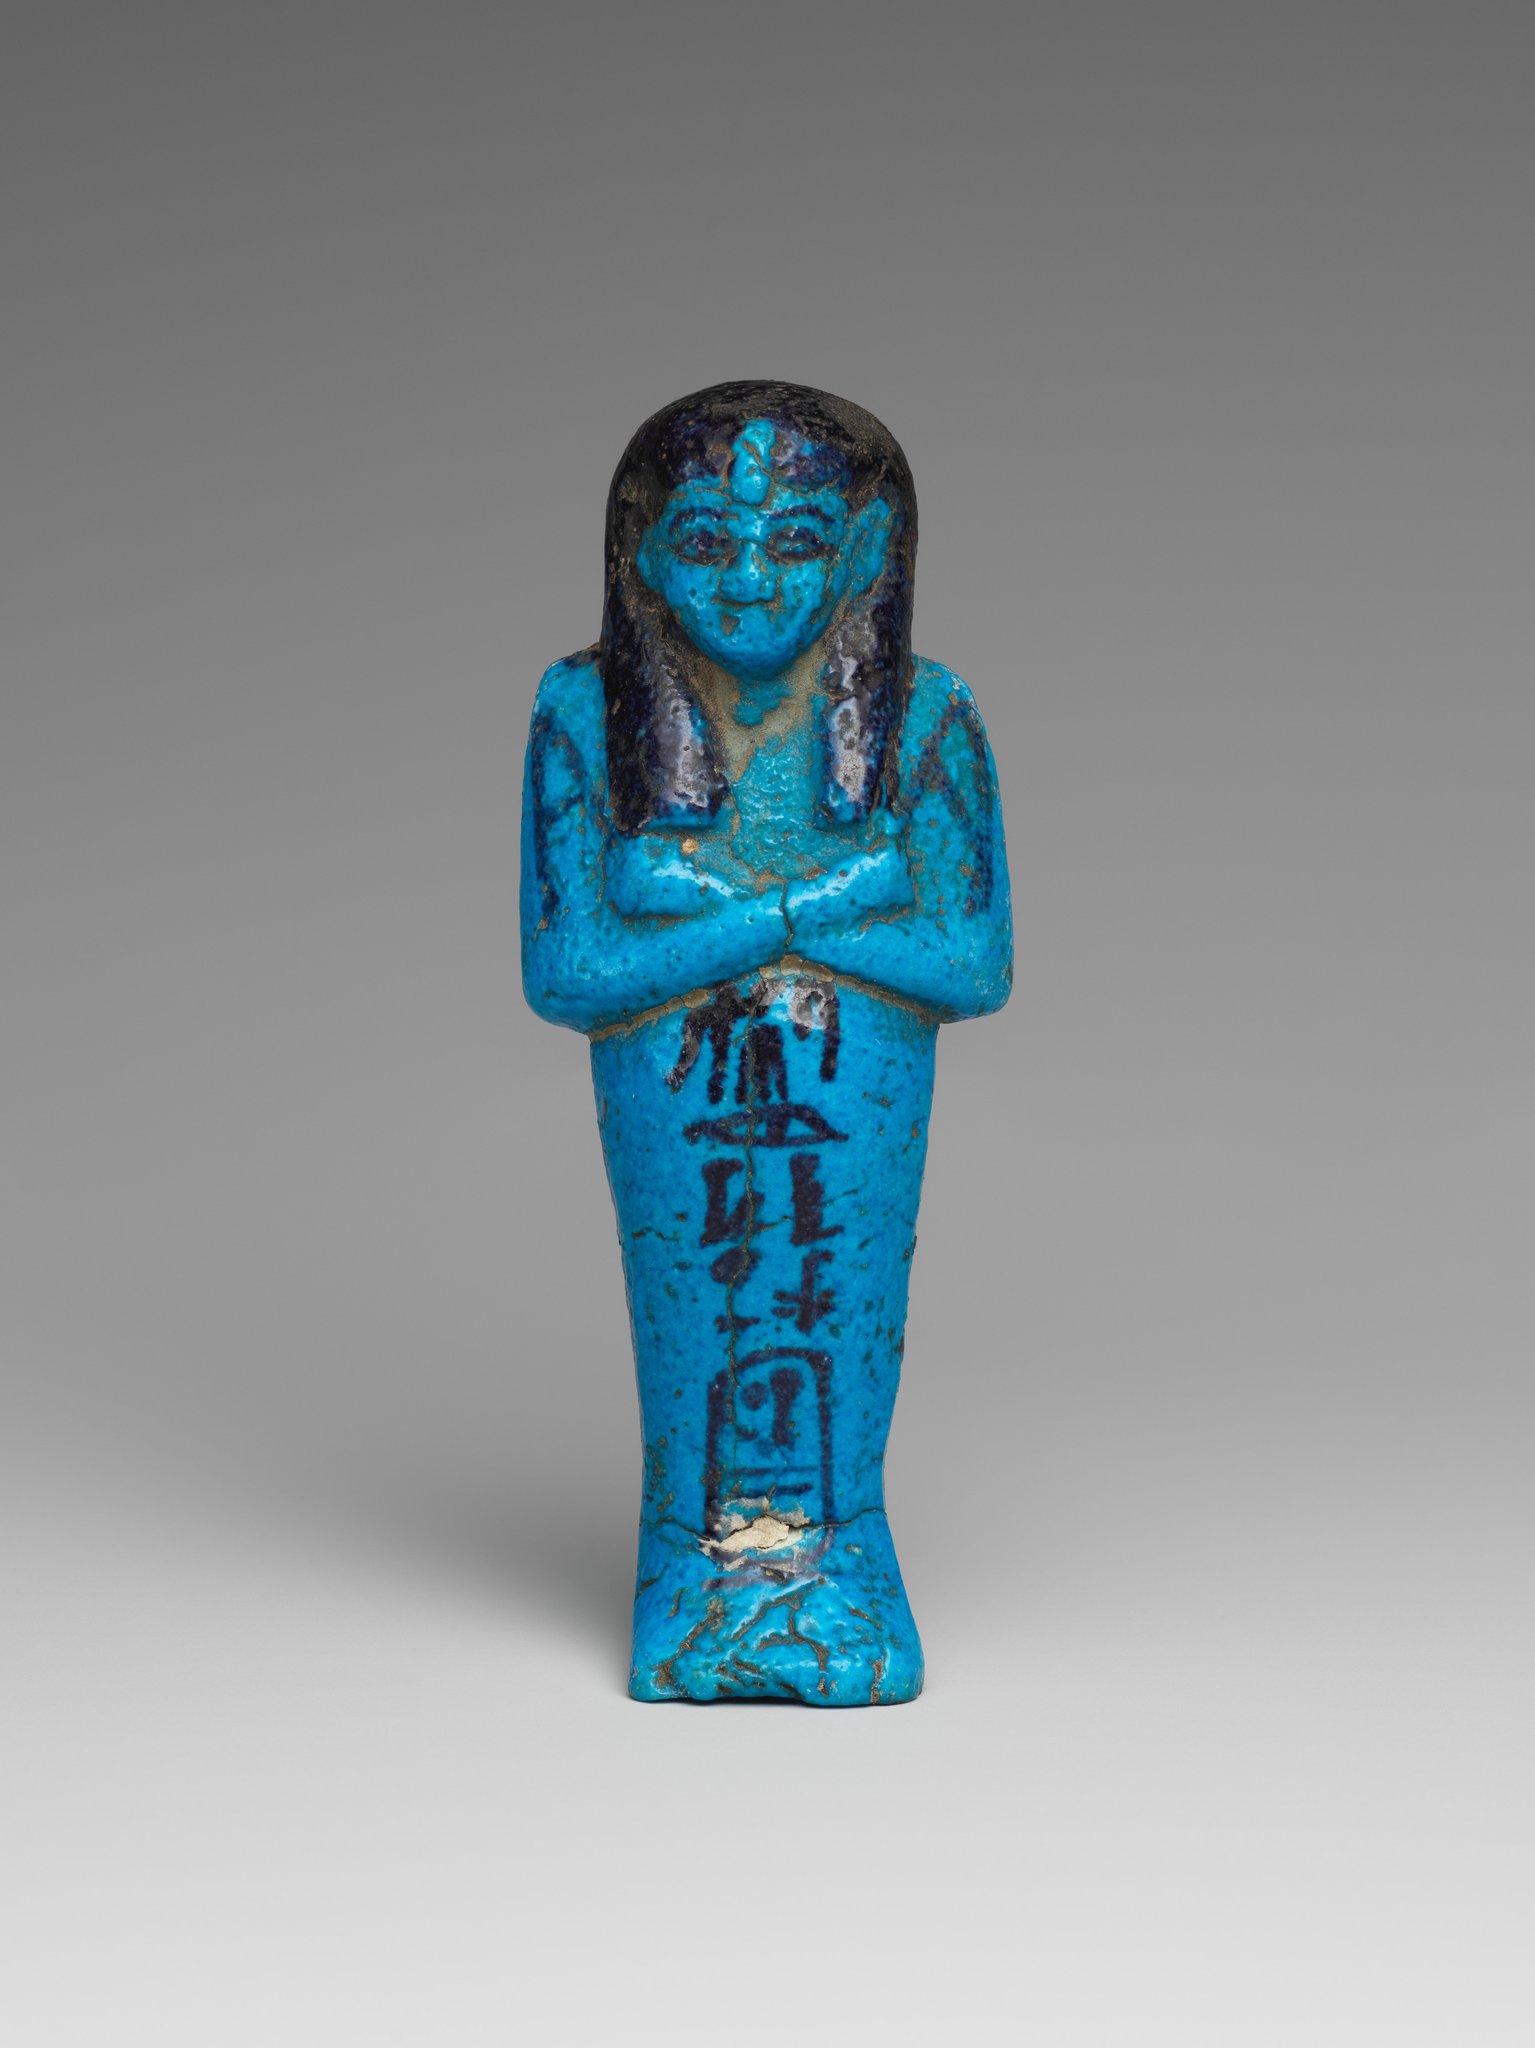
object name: shabti, queen henettawy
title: Shabti of the Adoratrice of Hathor Henettawy, wife of Painedjem I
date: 1064-1055 BCE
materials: faience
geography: upper egypt, thebes